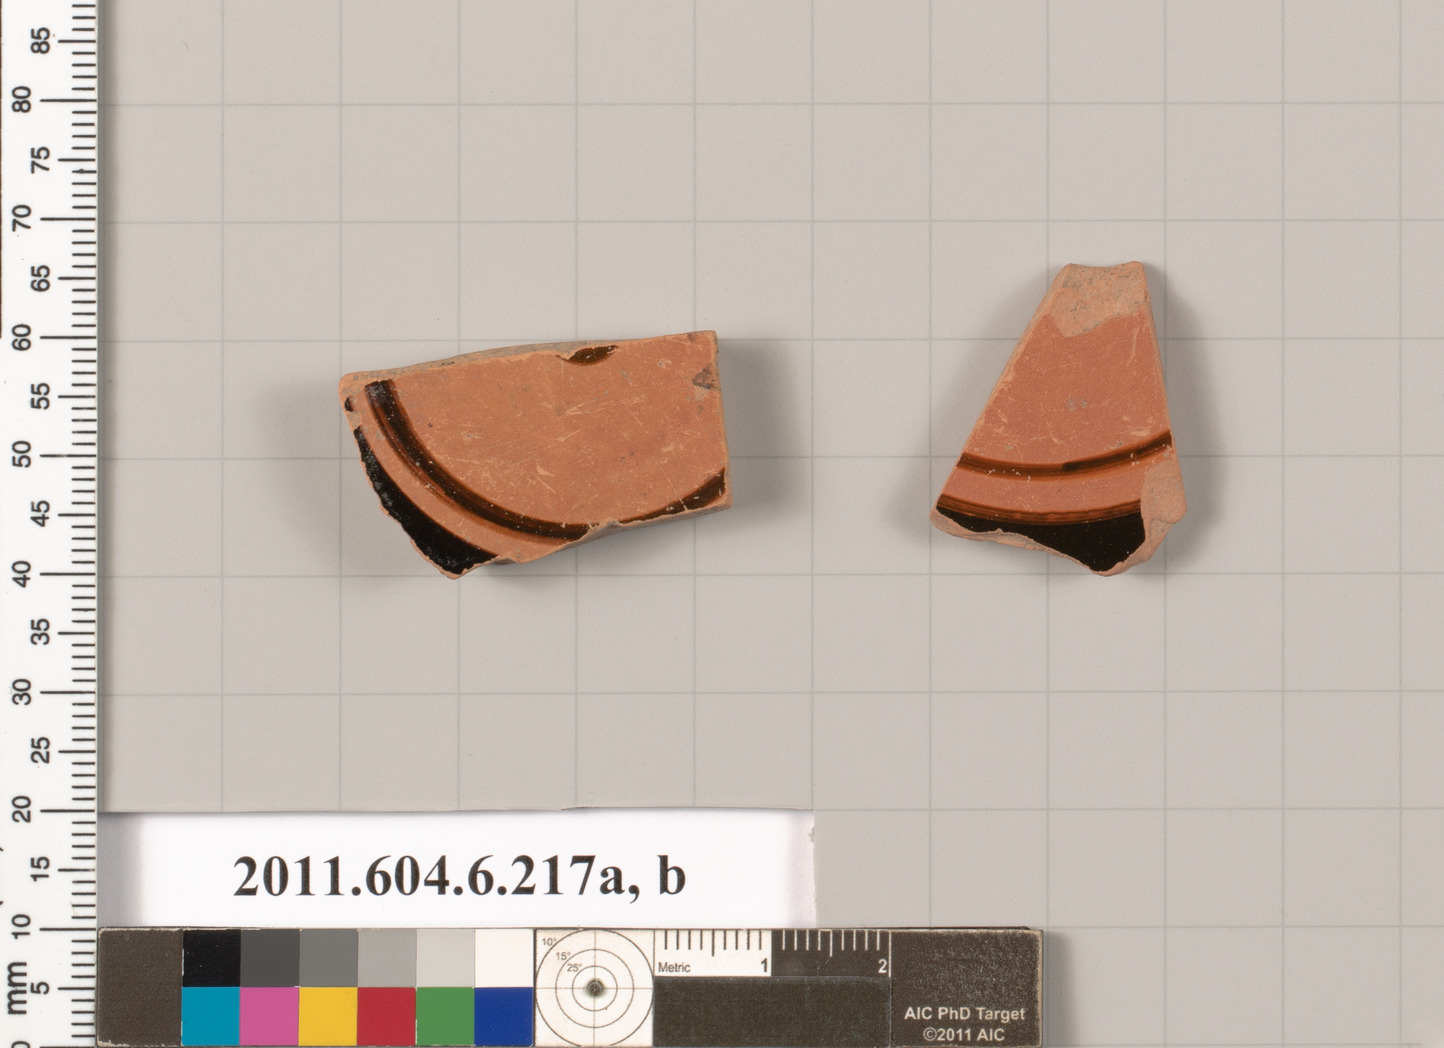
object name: undetermined open shape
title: Terracotta fragments of open shapes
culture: greek, attic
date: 600-401 BCE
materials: terracotta